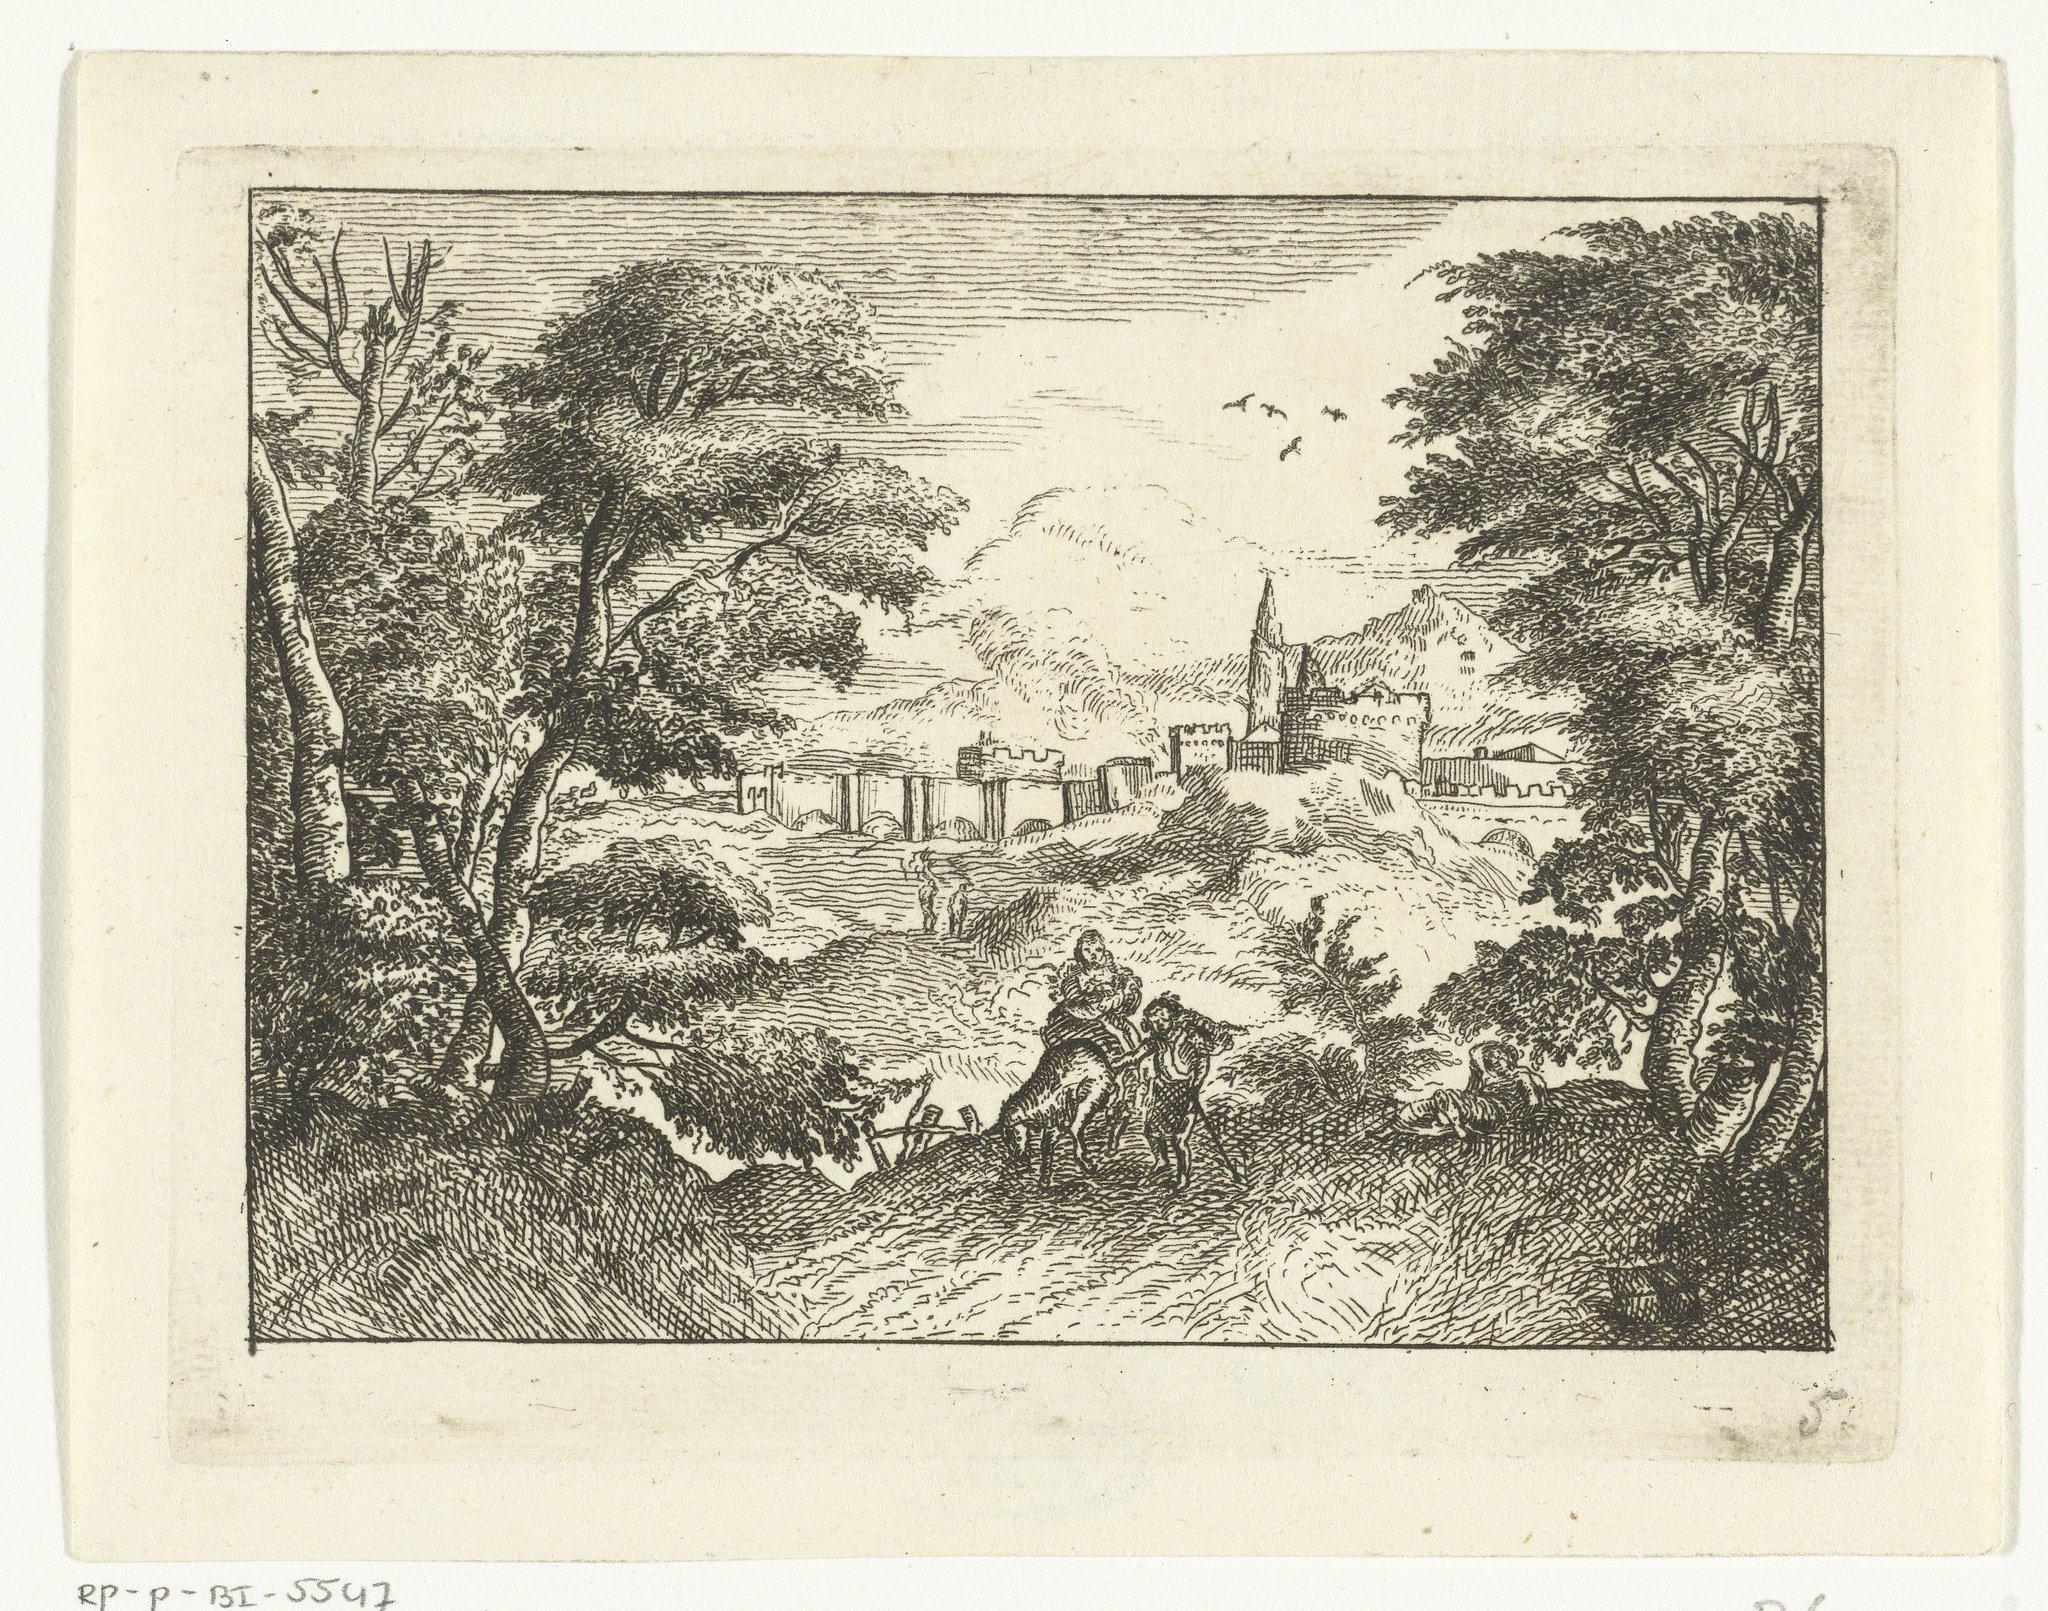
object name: print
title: Vlucht naar Egypte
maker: Anonymous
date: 1648-1755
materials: paper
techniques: etching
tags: landscapes, the flight into egypt: mary, joseph, the child (and sometimes others) on their way; mary usually riding on an ass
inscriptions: collector's mark: Lugt 2228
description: Landschap met man lopend naast ezel waarop vrouw met kind. Naast het pad, onder de bomen, een liggend persoon en op de achtergrond een stad.